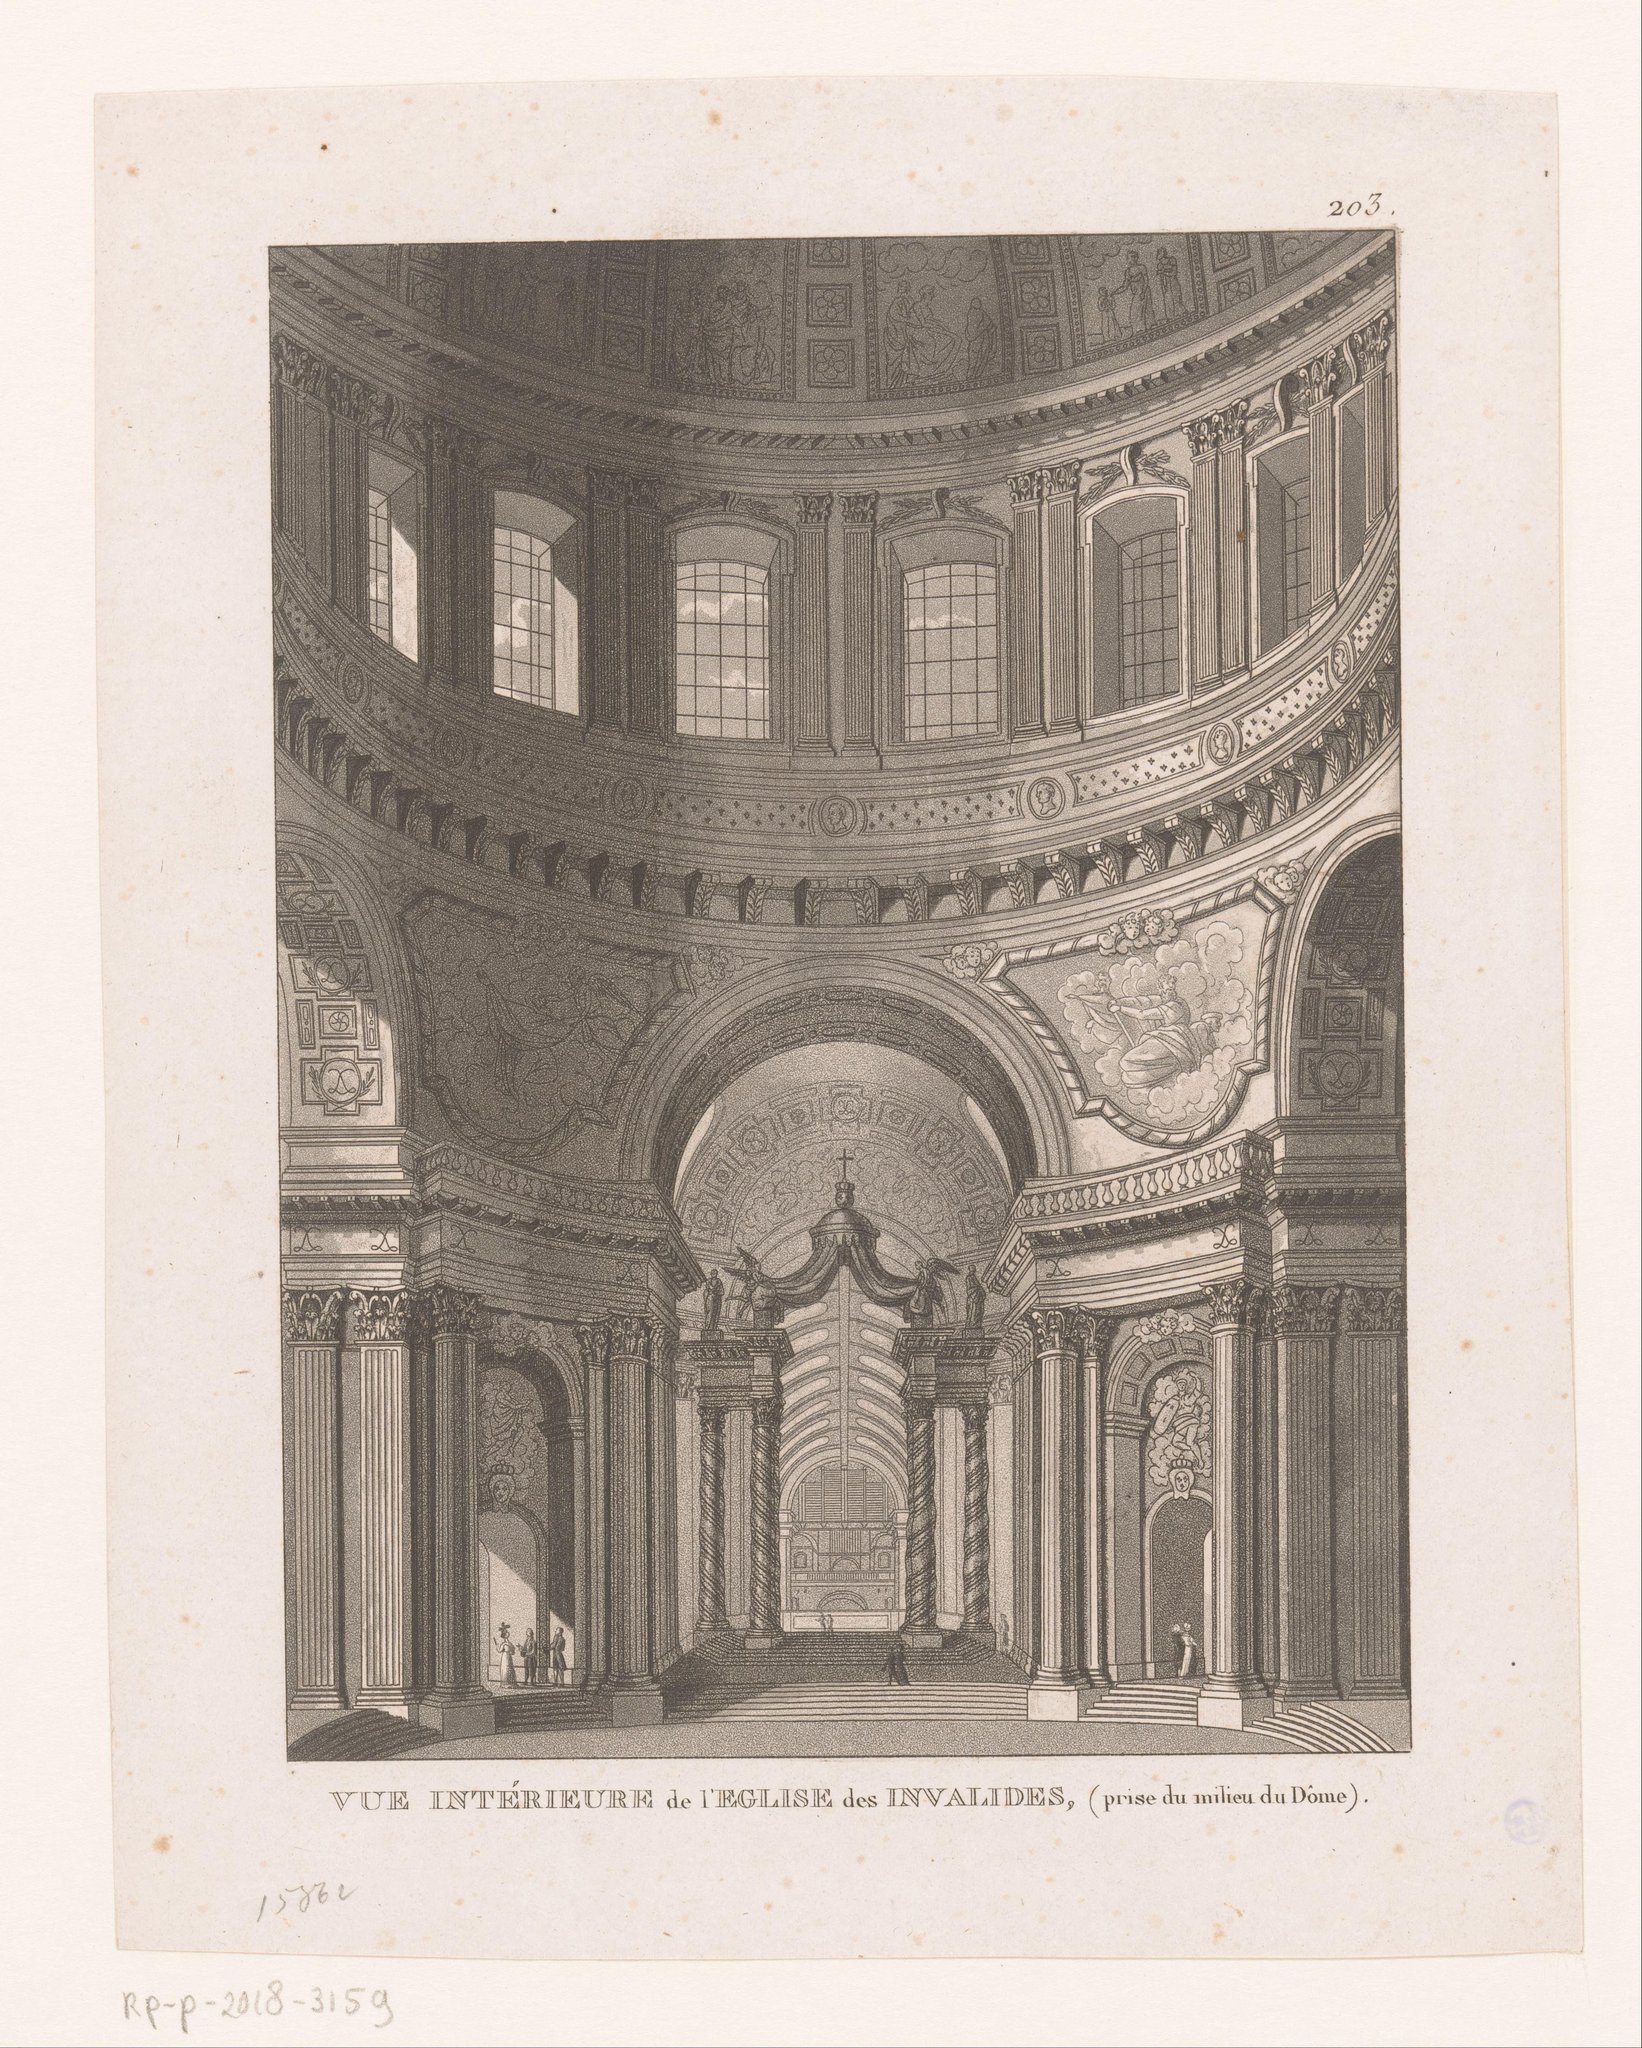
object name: print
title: Vue intérieure de l'Eglise des Invalides (prise du milieu du Dôme)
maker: Anonymous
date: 1800-1850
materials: paper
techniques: aquatint, etching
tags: roman catholic church, interior of church, architecture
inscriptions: collector's mark: Lugt 1337, collector's mark: Lugt 2228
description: Prent maakt mogelijk deel uit van een serie.